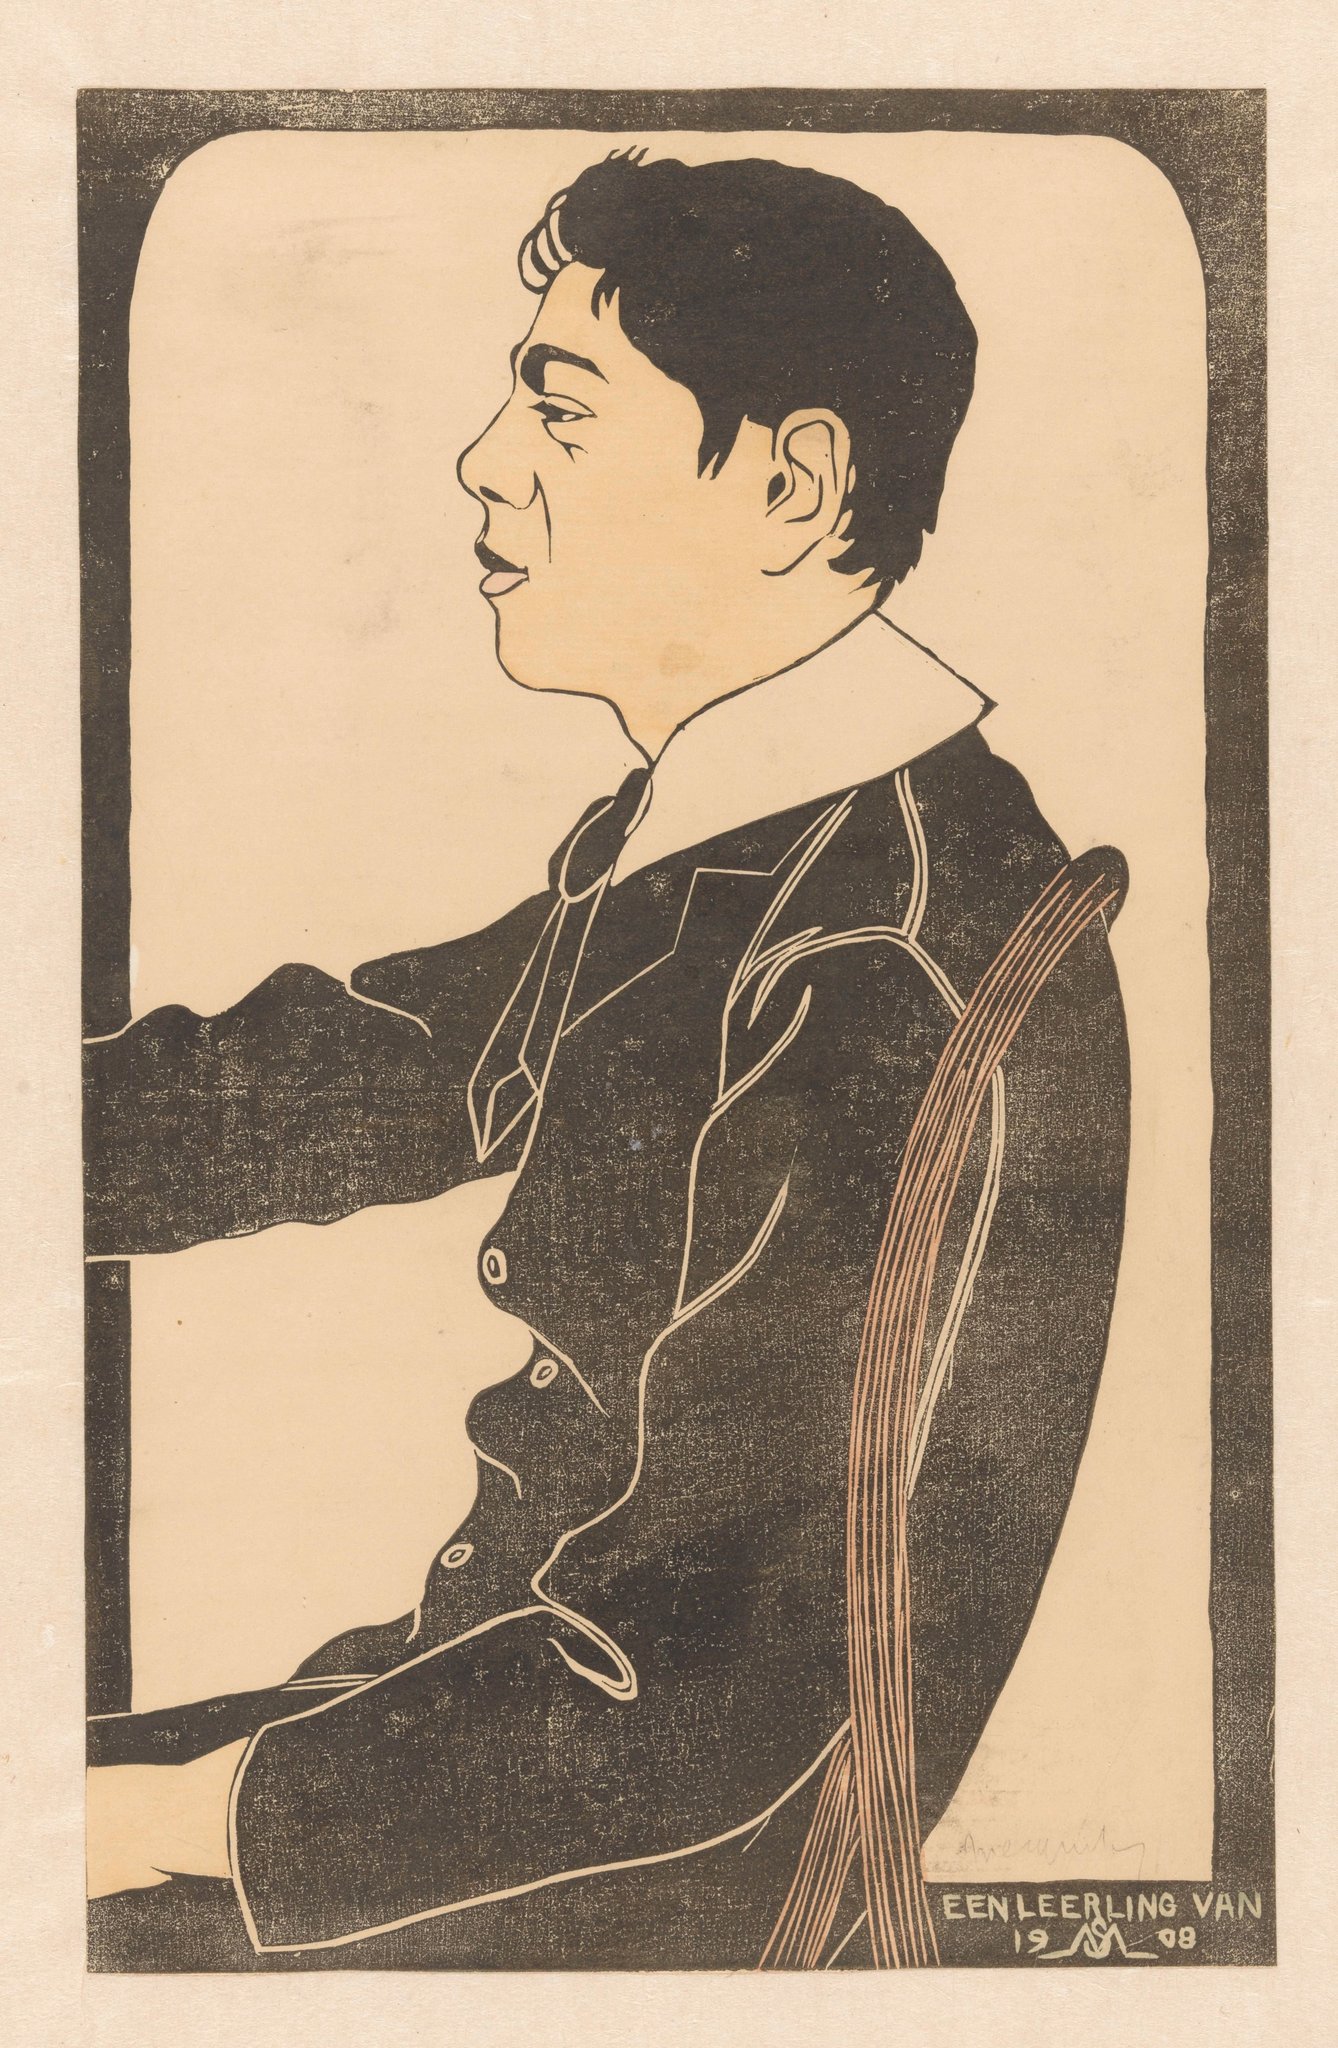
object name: print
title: Een leerling van 1908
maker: samuel jessurun de mesquita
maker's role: draughtsman, print maker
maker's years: 1868-1944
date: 1908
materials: paper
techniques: woodcut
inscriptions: title: ‘EEN LEERLING VAN 1908’, monogram: ‘SM’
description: Jongen met das en colbert, en profil en ten halven lijve weergegeven, zittend op een stoel met gebogen houten leuning.